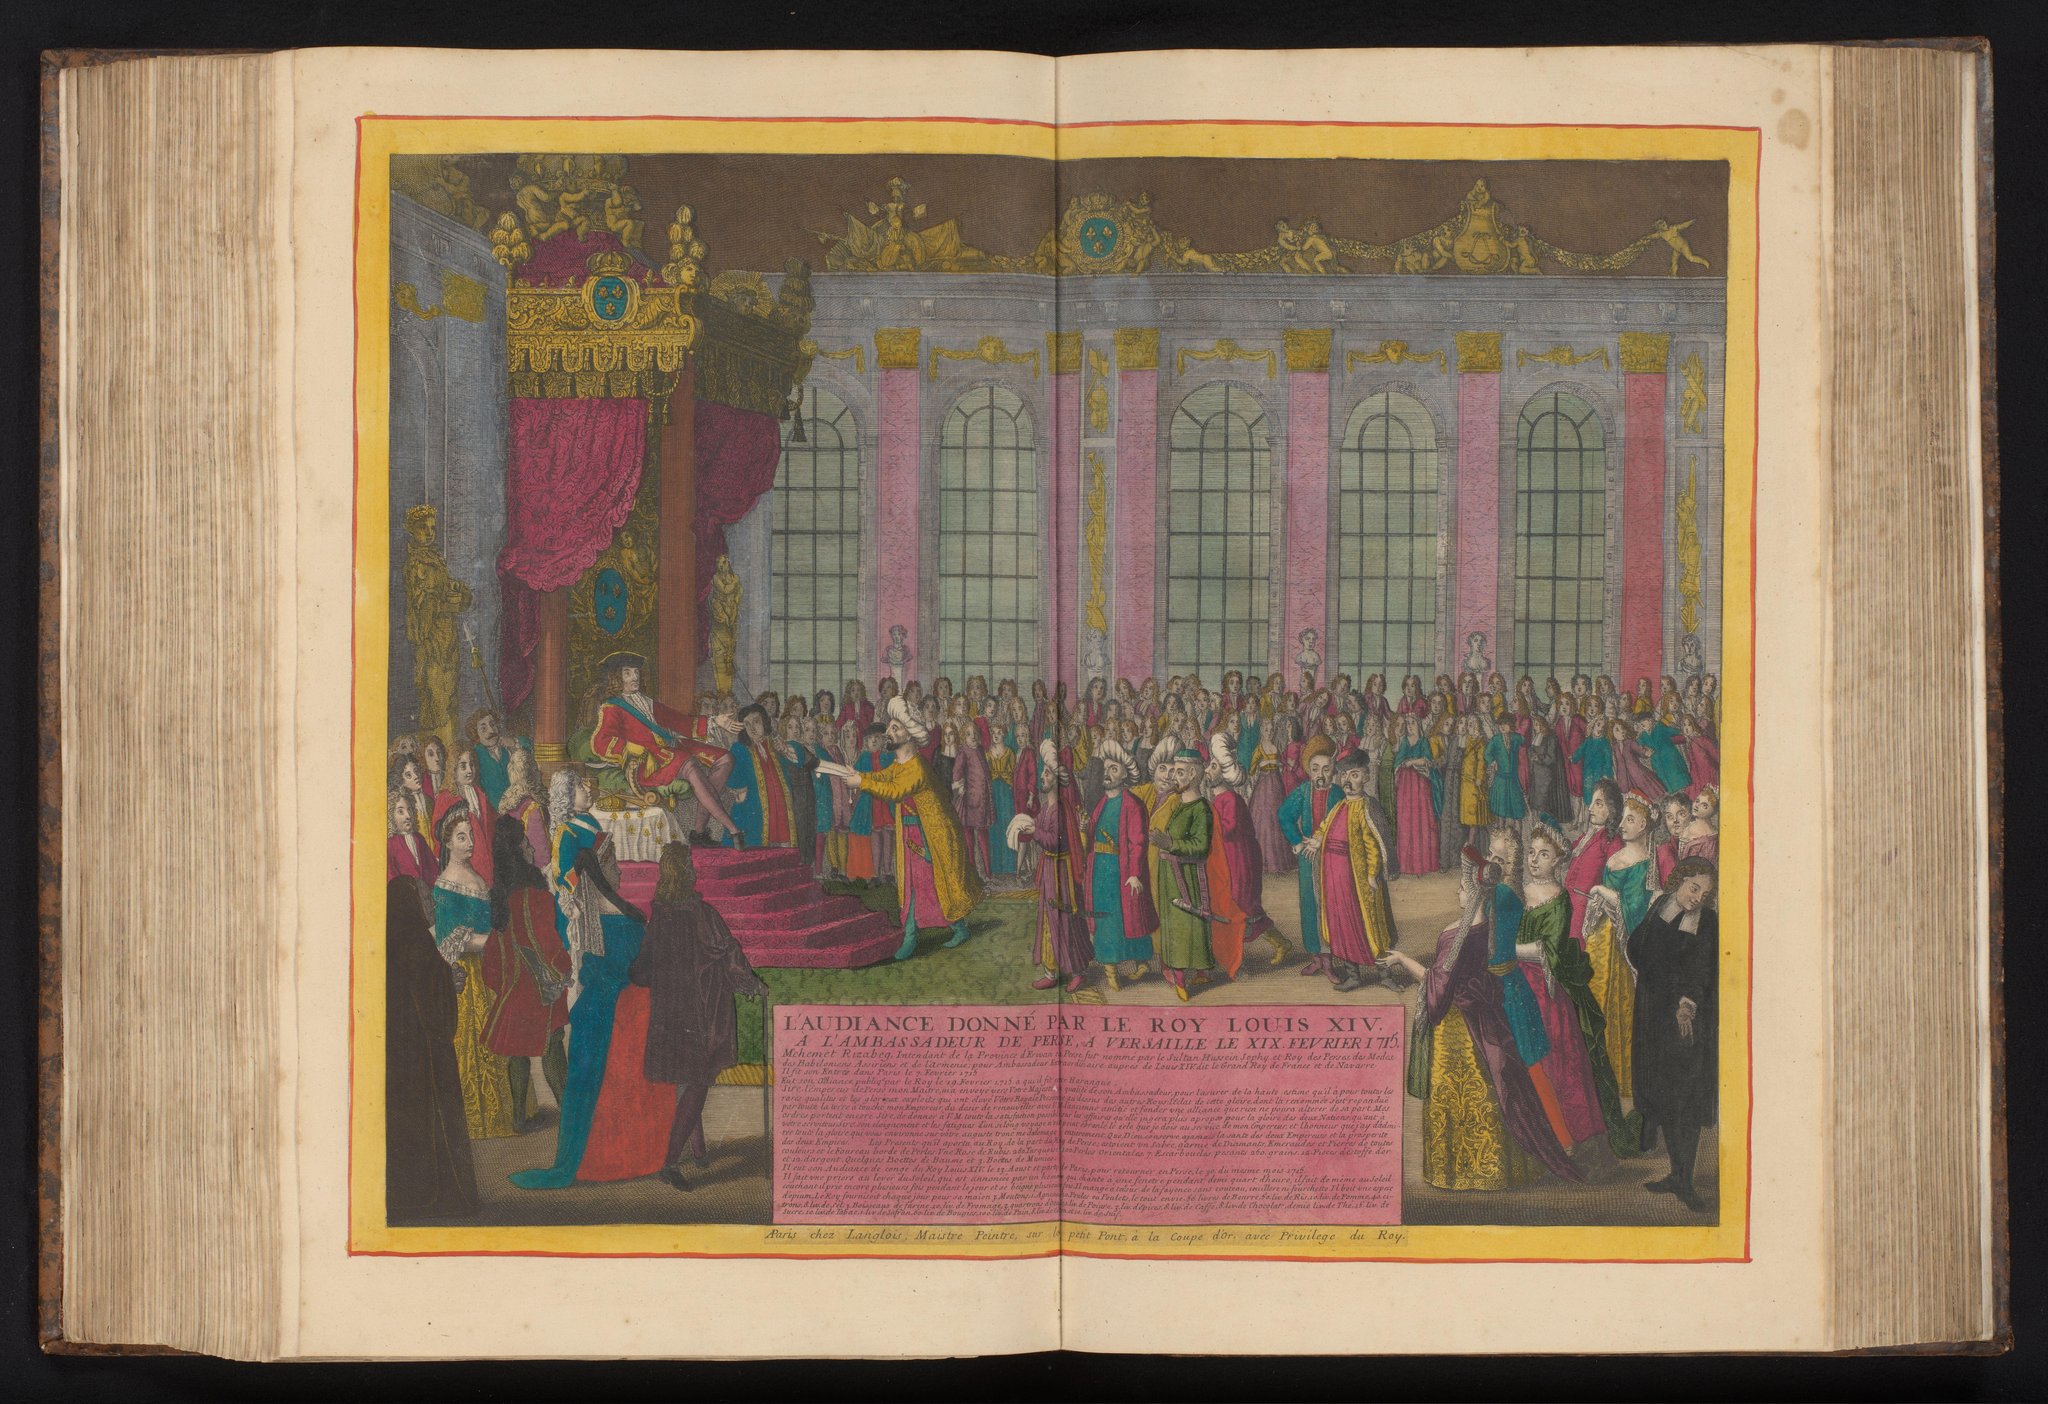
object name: album leaf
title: L'Audiance donné par le Roy Louis XIV à l'Ambassadeur de Perse, à Versaille le XIX. Fevrier 1715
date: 1715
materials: paper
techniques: engraving, etching, hand coloring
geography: paris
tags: lodewijk xiv (koning van frankrijk), audition; ruler giving audience, reception ~ ambassador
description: Koning Lodewijk XIV, gezeten op zijn troon, ontvangt de Perzische ambassadeur Mohammad Reza Beg in het Paleis van Versailles op 19 februari 1715. De Perzische ambassadeur biedt een akte aan de koning aan. Rondom kijken mannen en vrouwen toe. Prent maakt deel uit van een album.